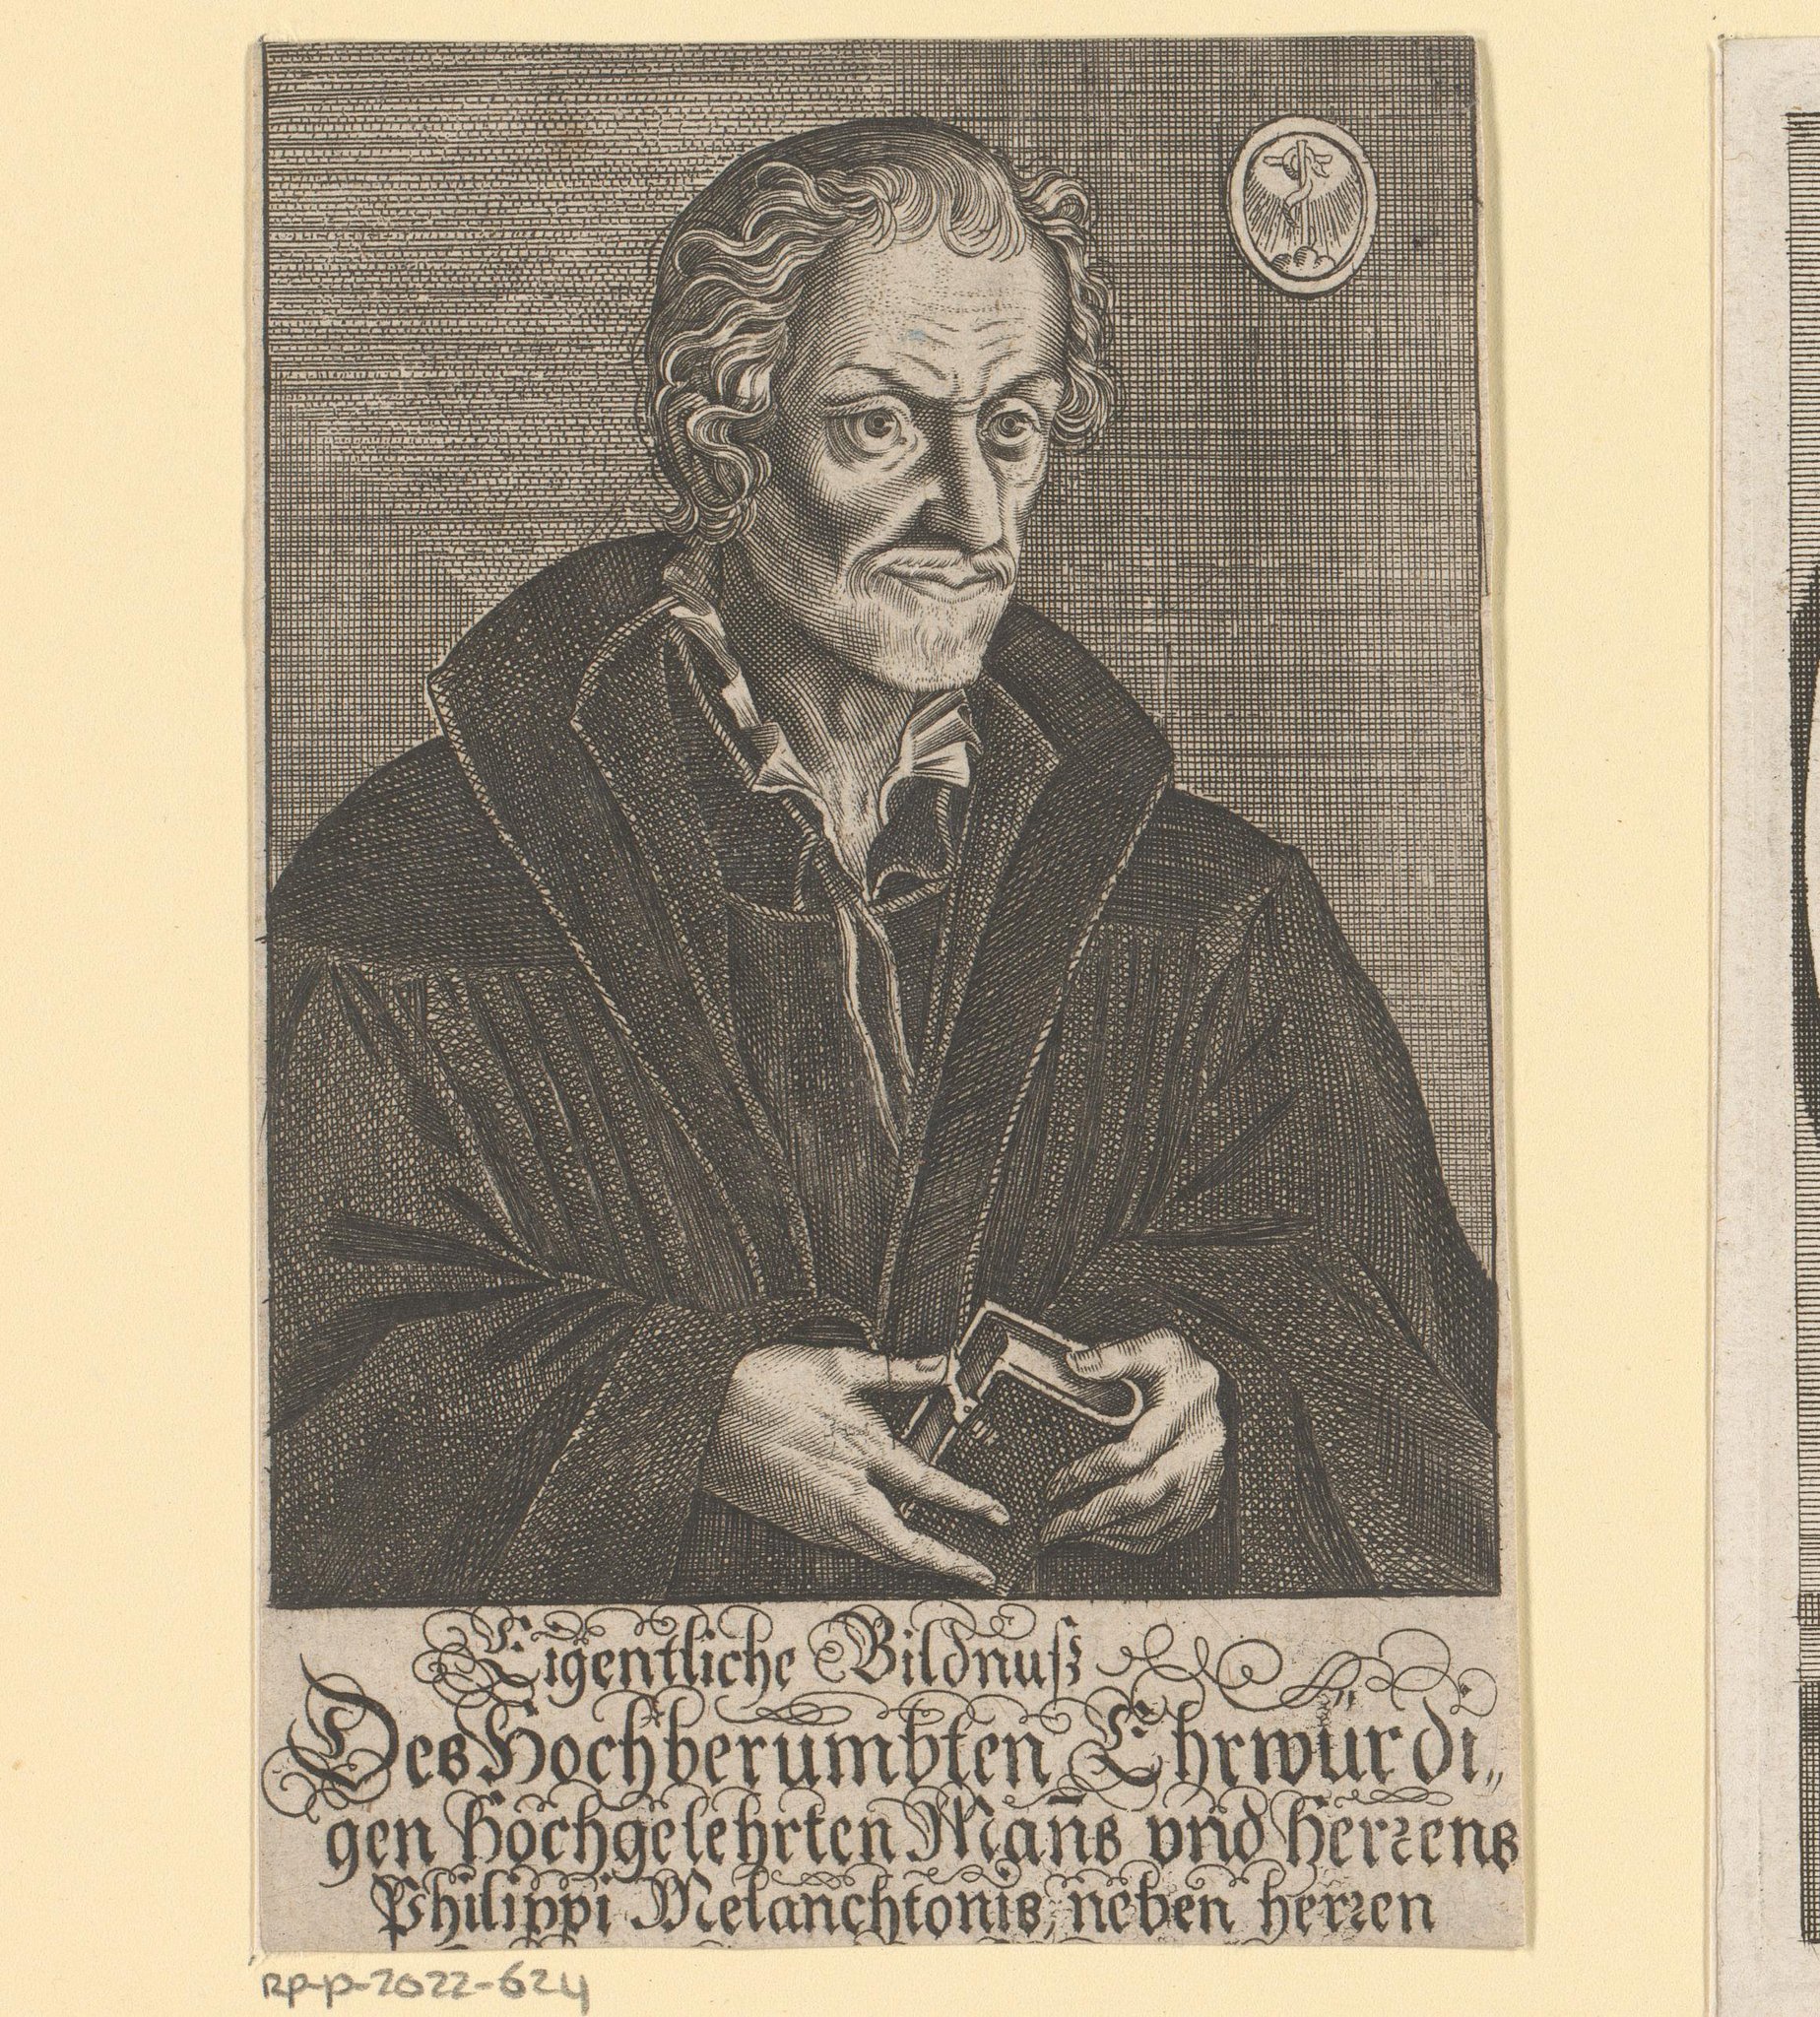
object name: print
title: Portret van Philipp Melanchthon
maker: Anonymous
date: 1600-1750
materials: paper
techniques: engraving, etching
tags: theologian, historical persons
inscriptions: number: ‘1300’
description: Met vierregelig onderschrift in het Duits.